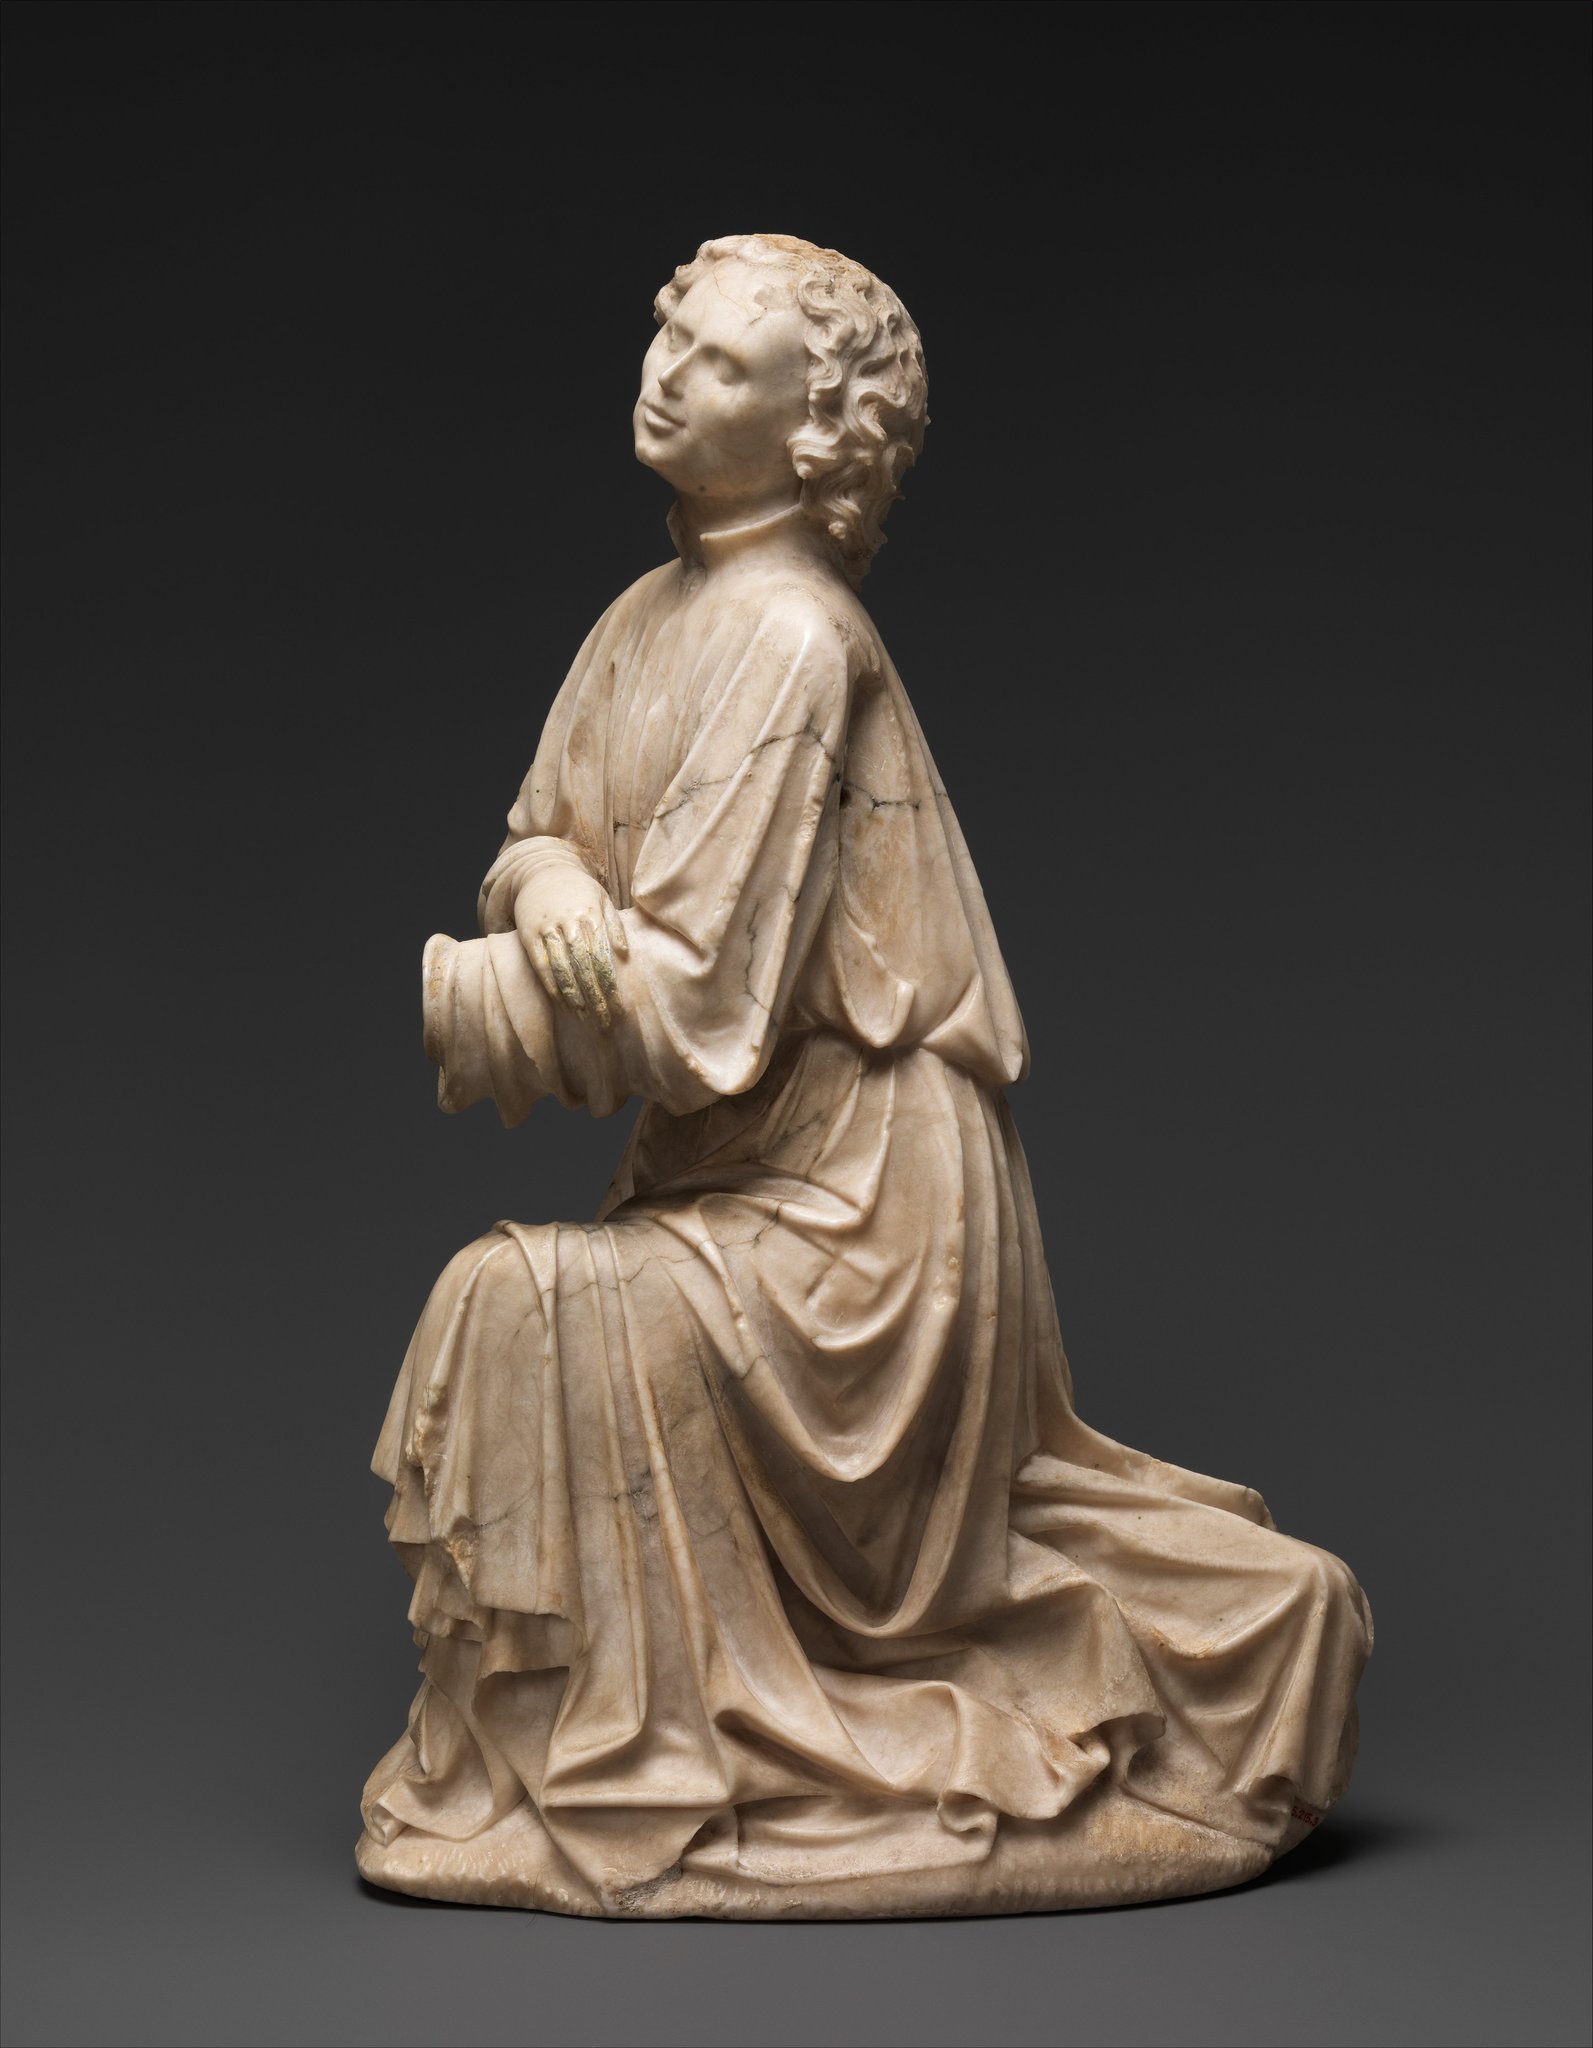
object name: statuette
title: Kneeling Angel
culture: german or south netherlandish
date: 1430-1440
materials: alabaster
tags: angels